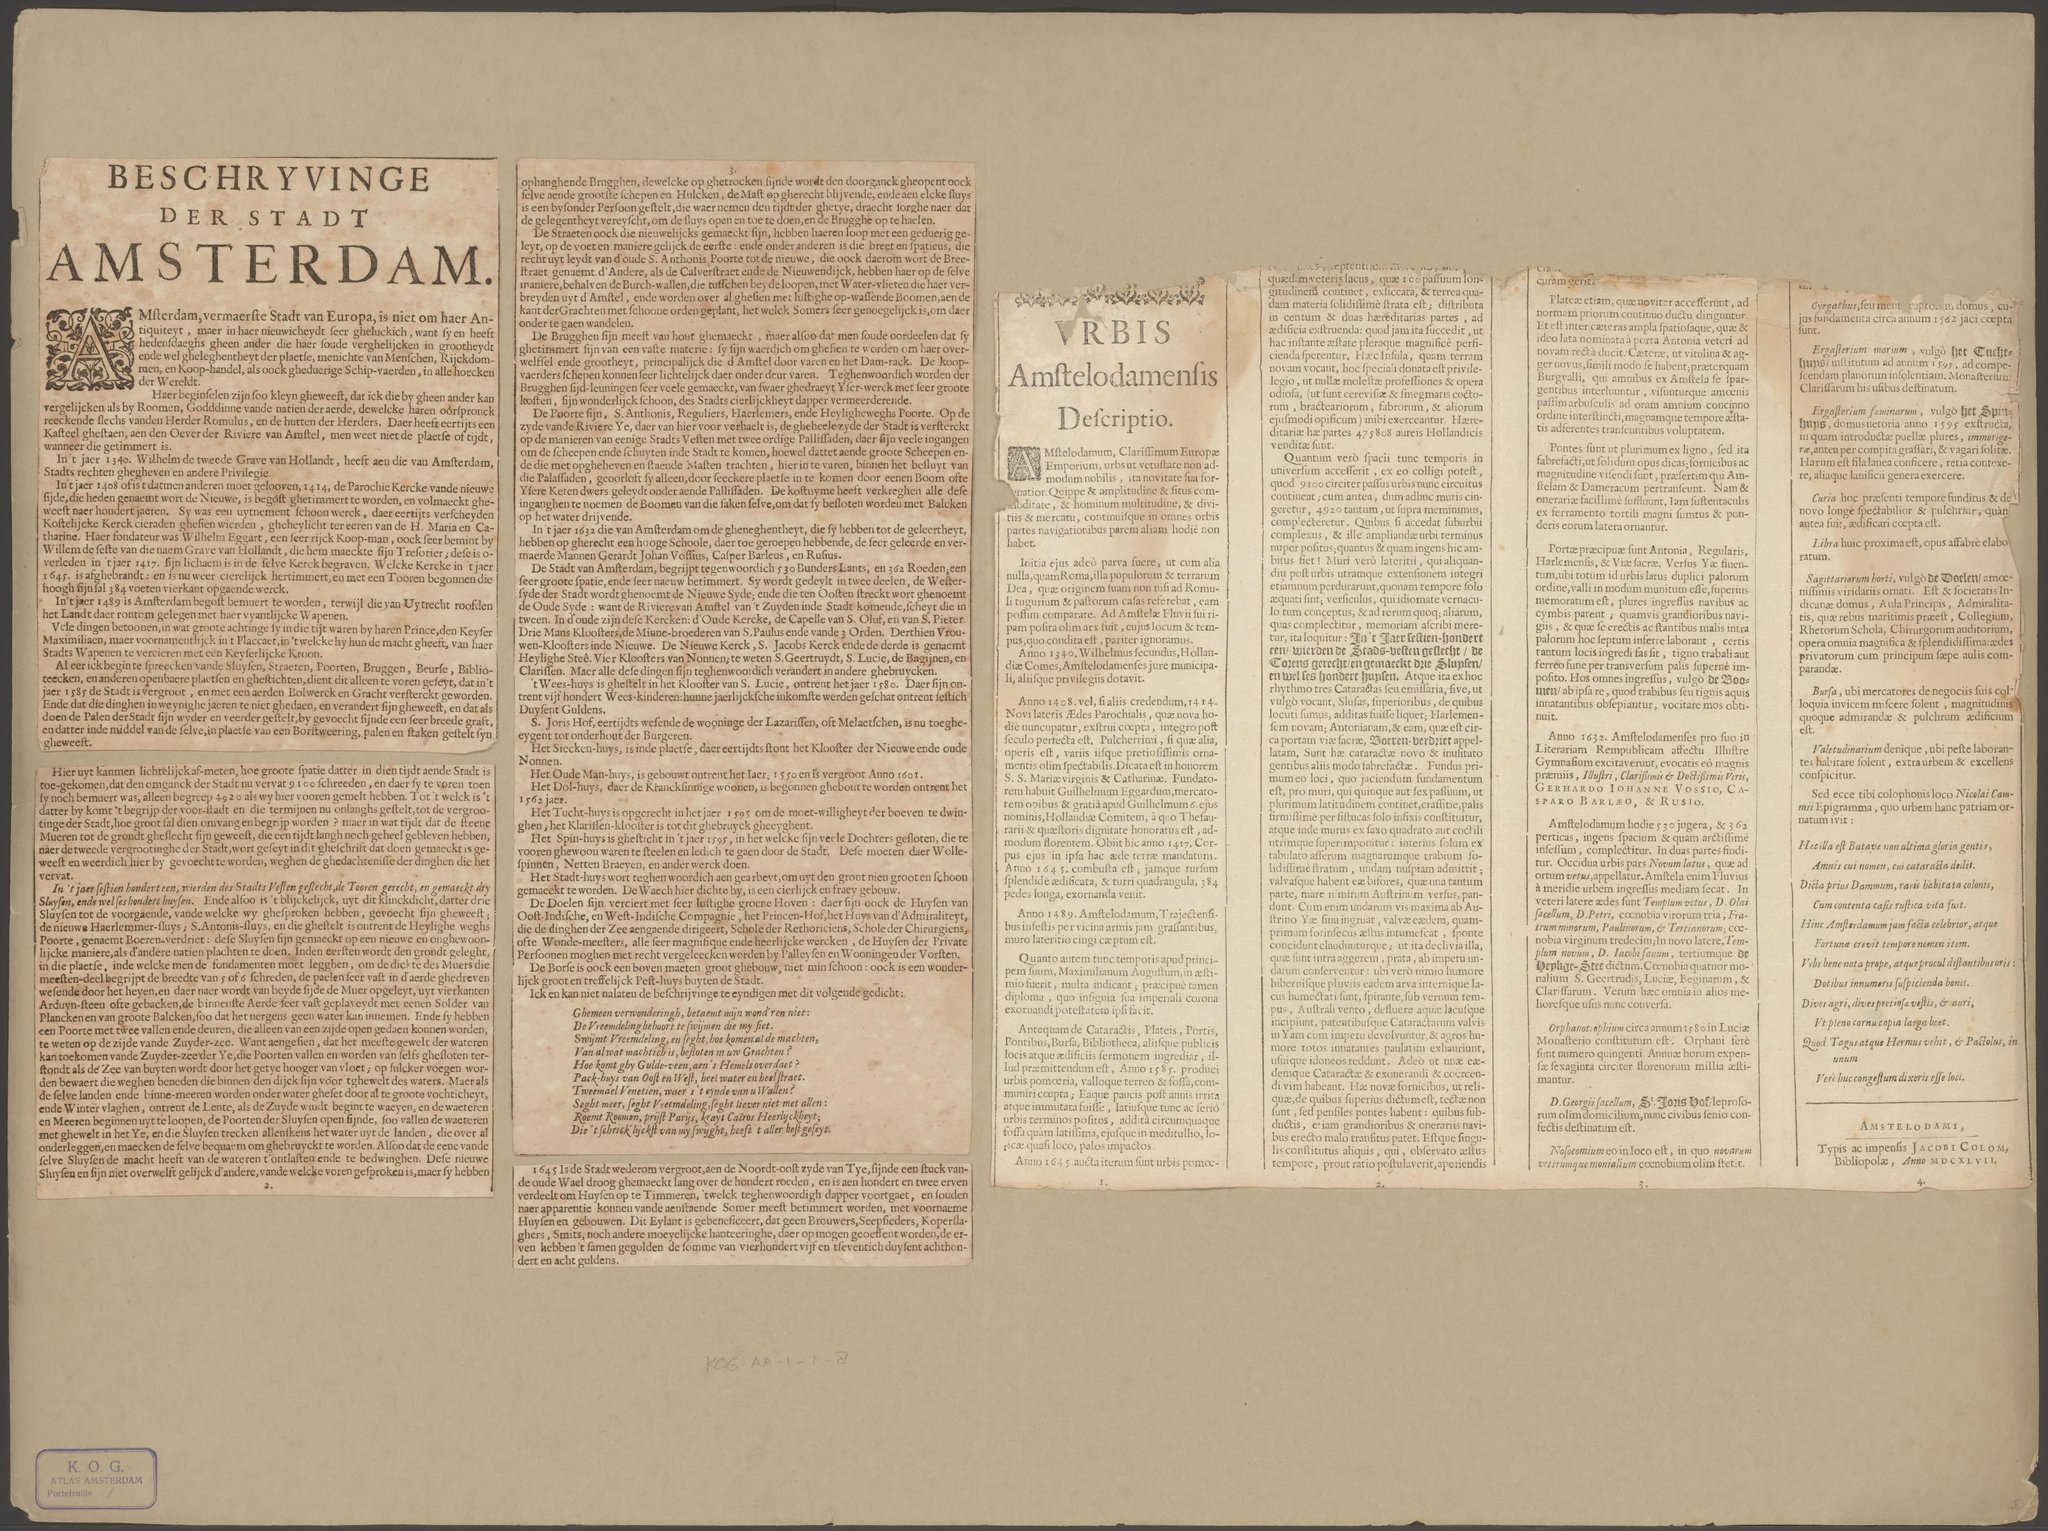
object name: text sheet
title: Twee tekstbladen met een Nederlandse en een Latijnse beschrijving van Amsterdam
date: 1647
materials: paper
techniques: letterpress printing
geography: amsterdam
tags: book, amsterdam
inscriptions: collector's mark: ‘1’ Lugt 1641b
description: Onderwerpsrubriek binnen de Atlas Amsterdam: Titels en voorberichten.